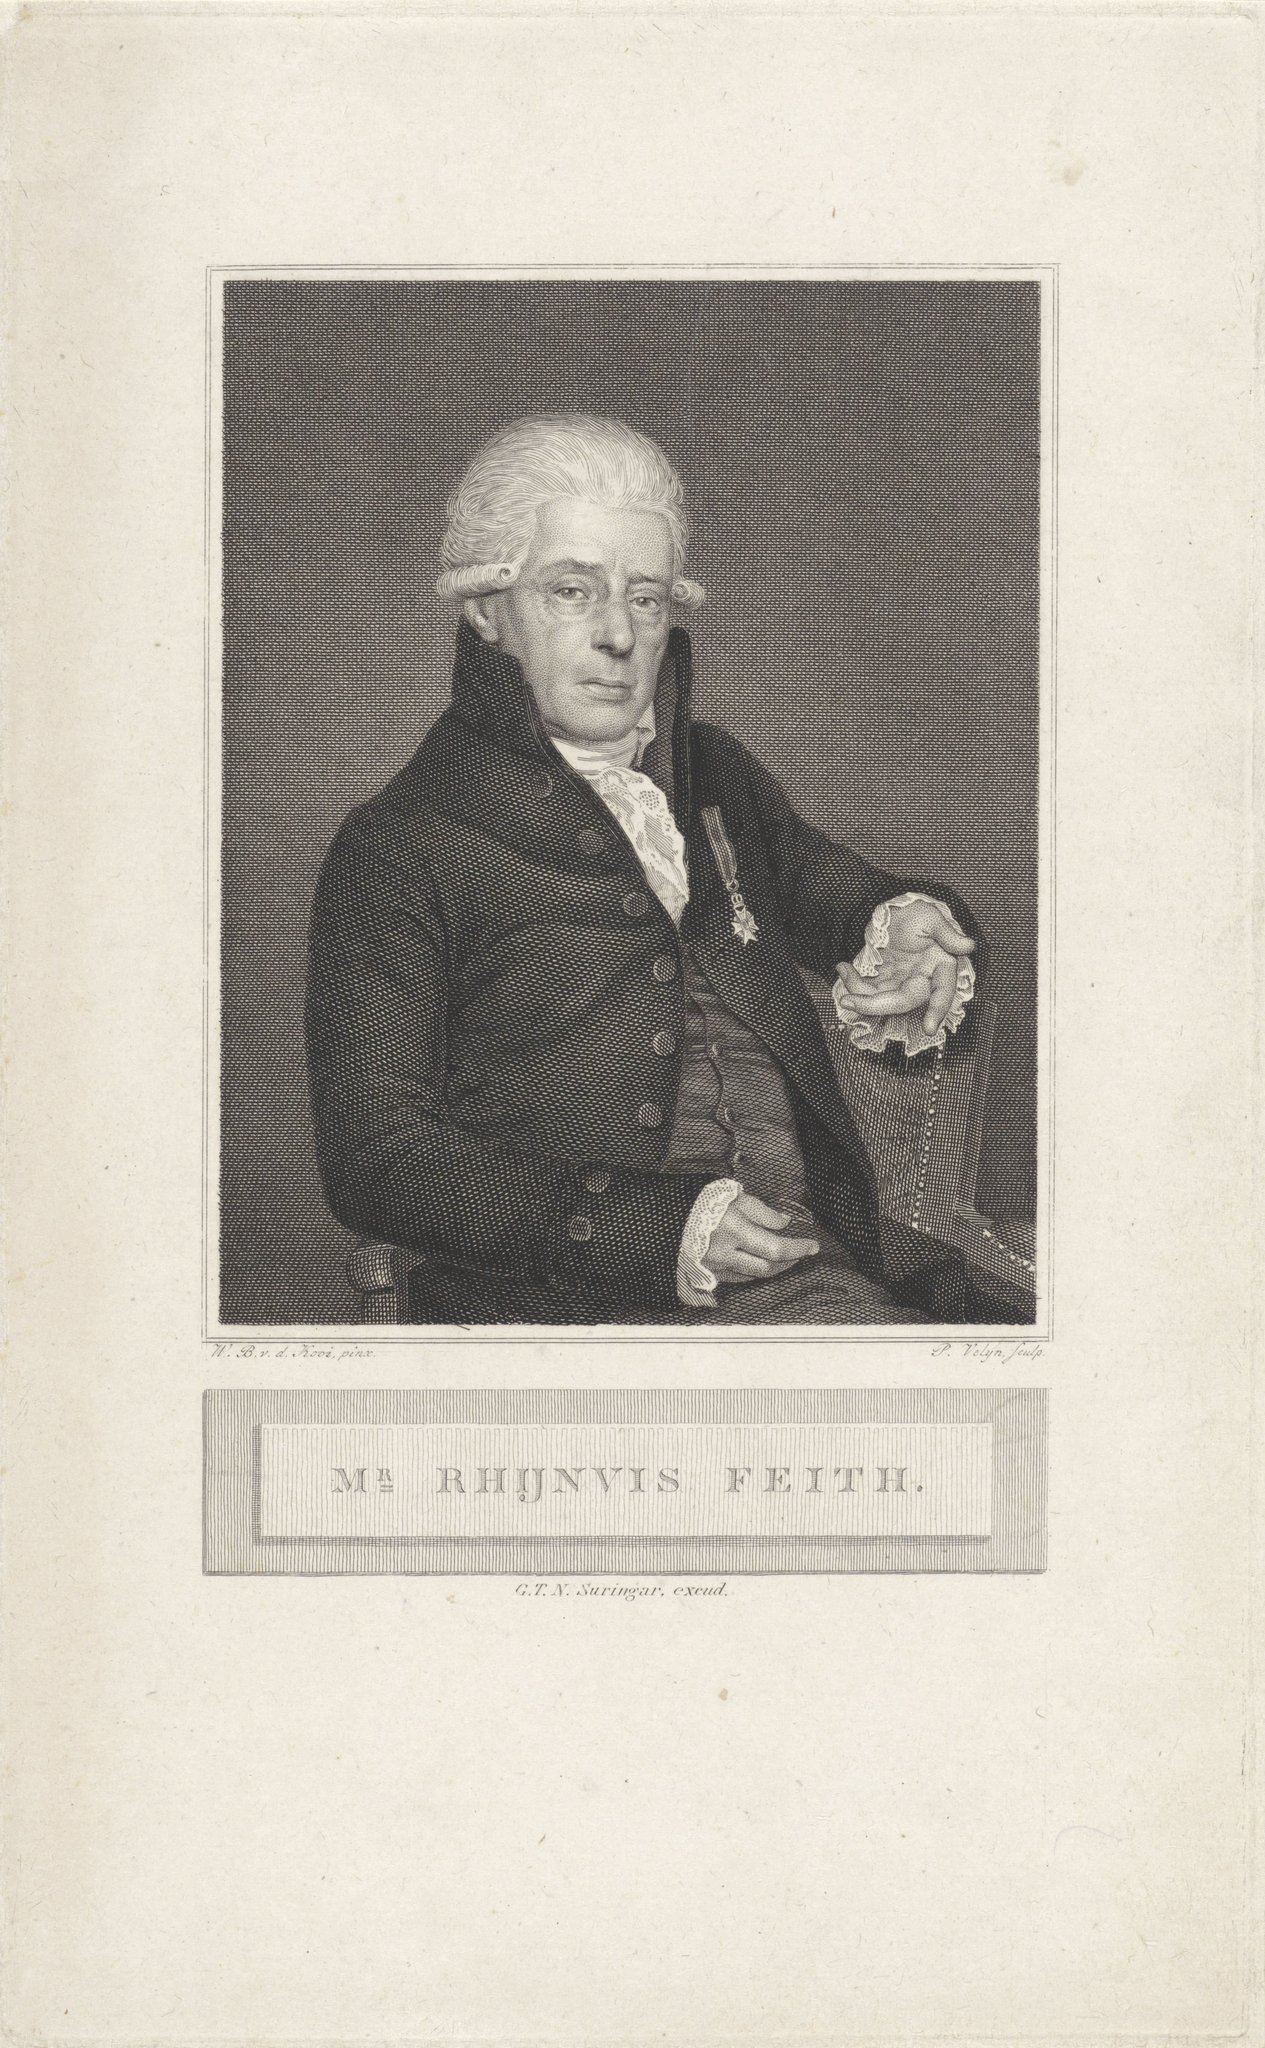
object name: print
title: Portret van Rijnvis Feith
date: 1804-1836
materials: paper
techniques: engraving, etching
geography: leeuwarden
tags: rhijnvis feith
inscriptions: collector's mark: Lugt 2228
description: Portret van de dichter en advocaat Rhijnvis Feith.